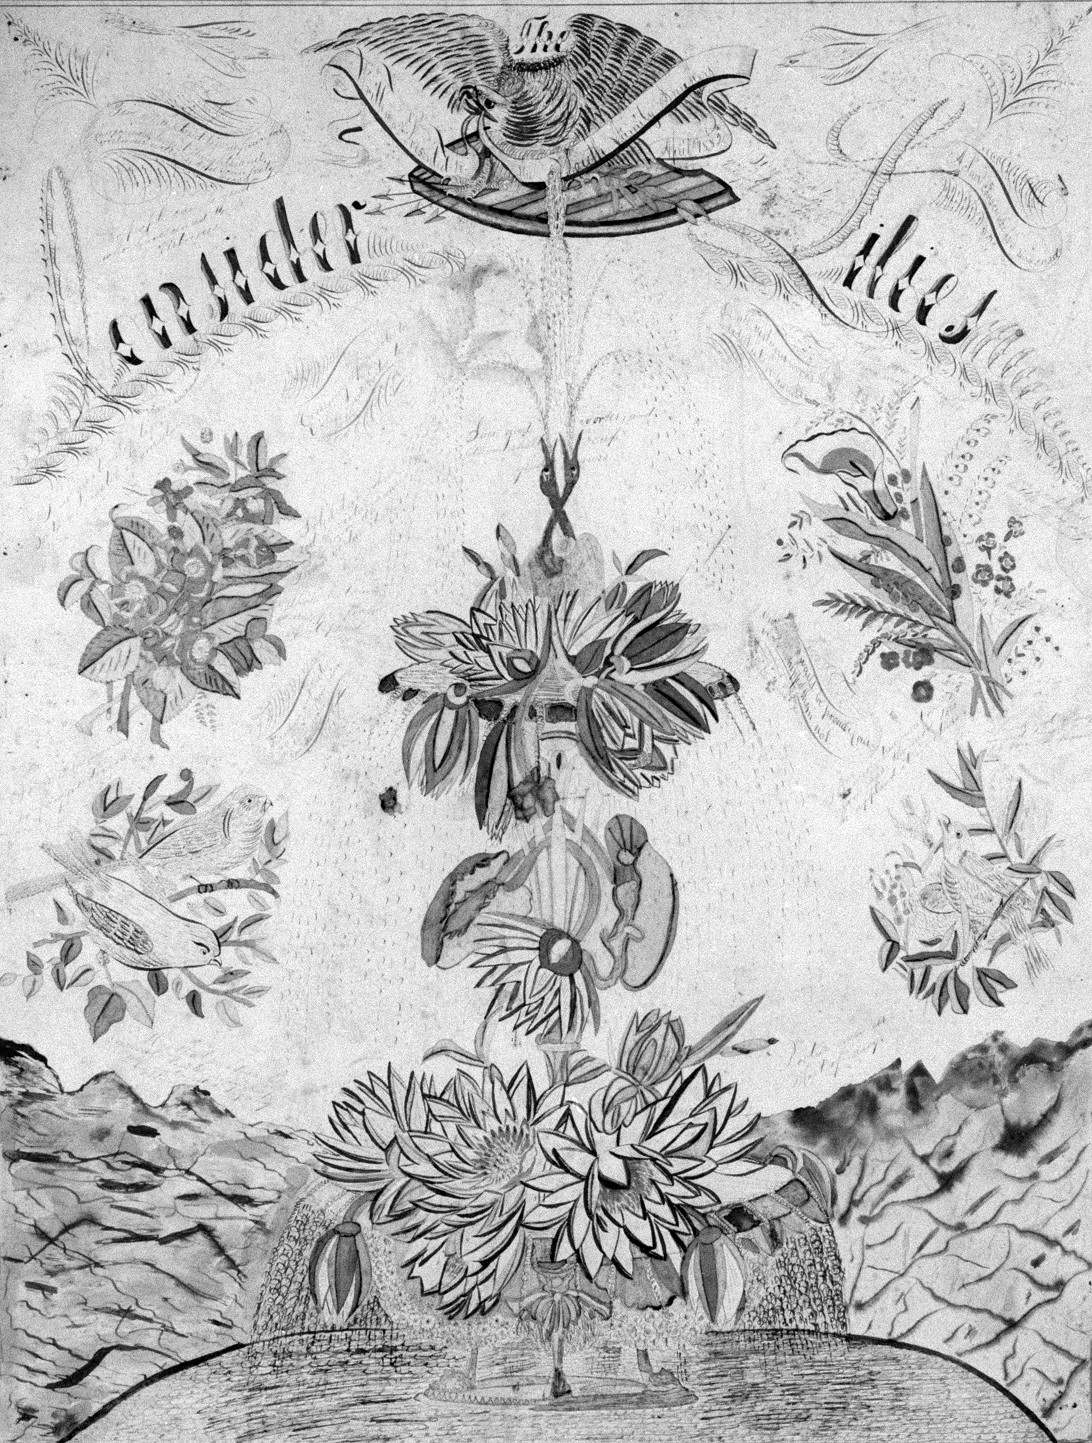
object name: watercolor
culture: american, shaker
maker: eugene b. cunningham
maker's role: artist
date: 1882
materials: ink, paper, watercolor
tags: birds,flowers,leaves